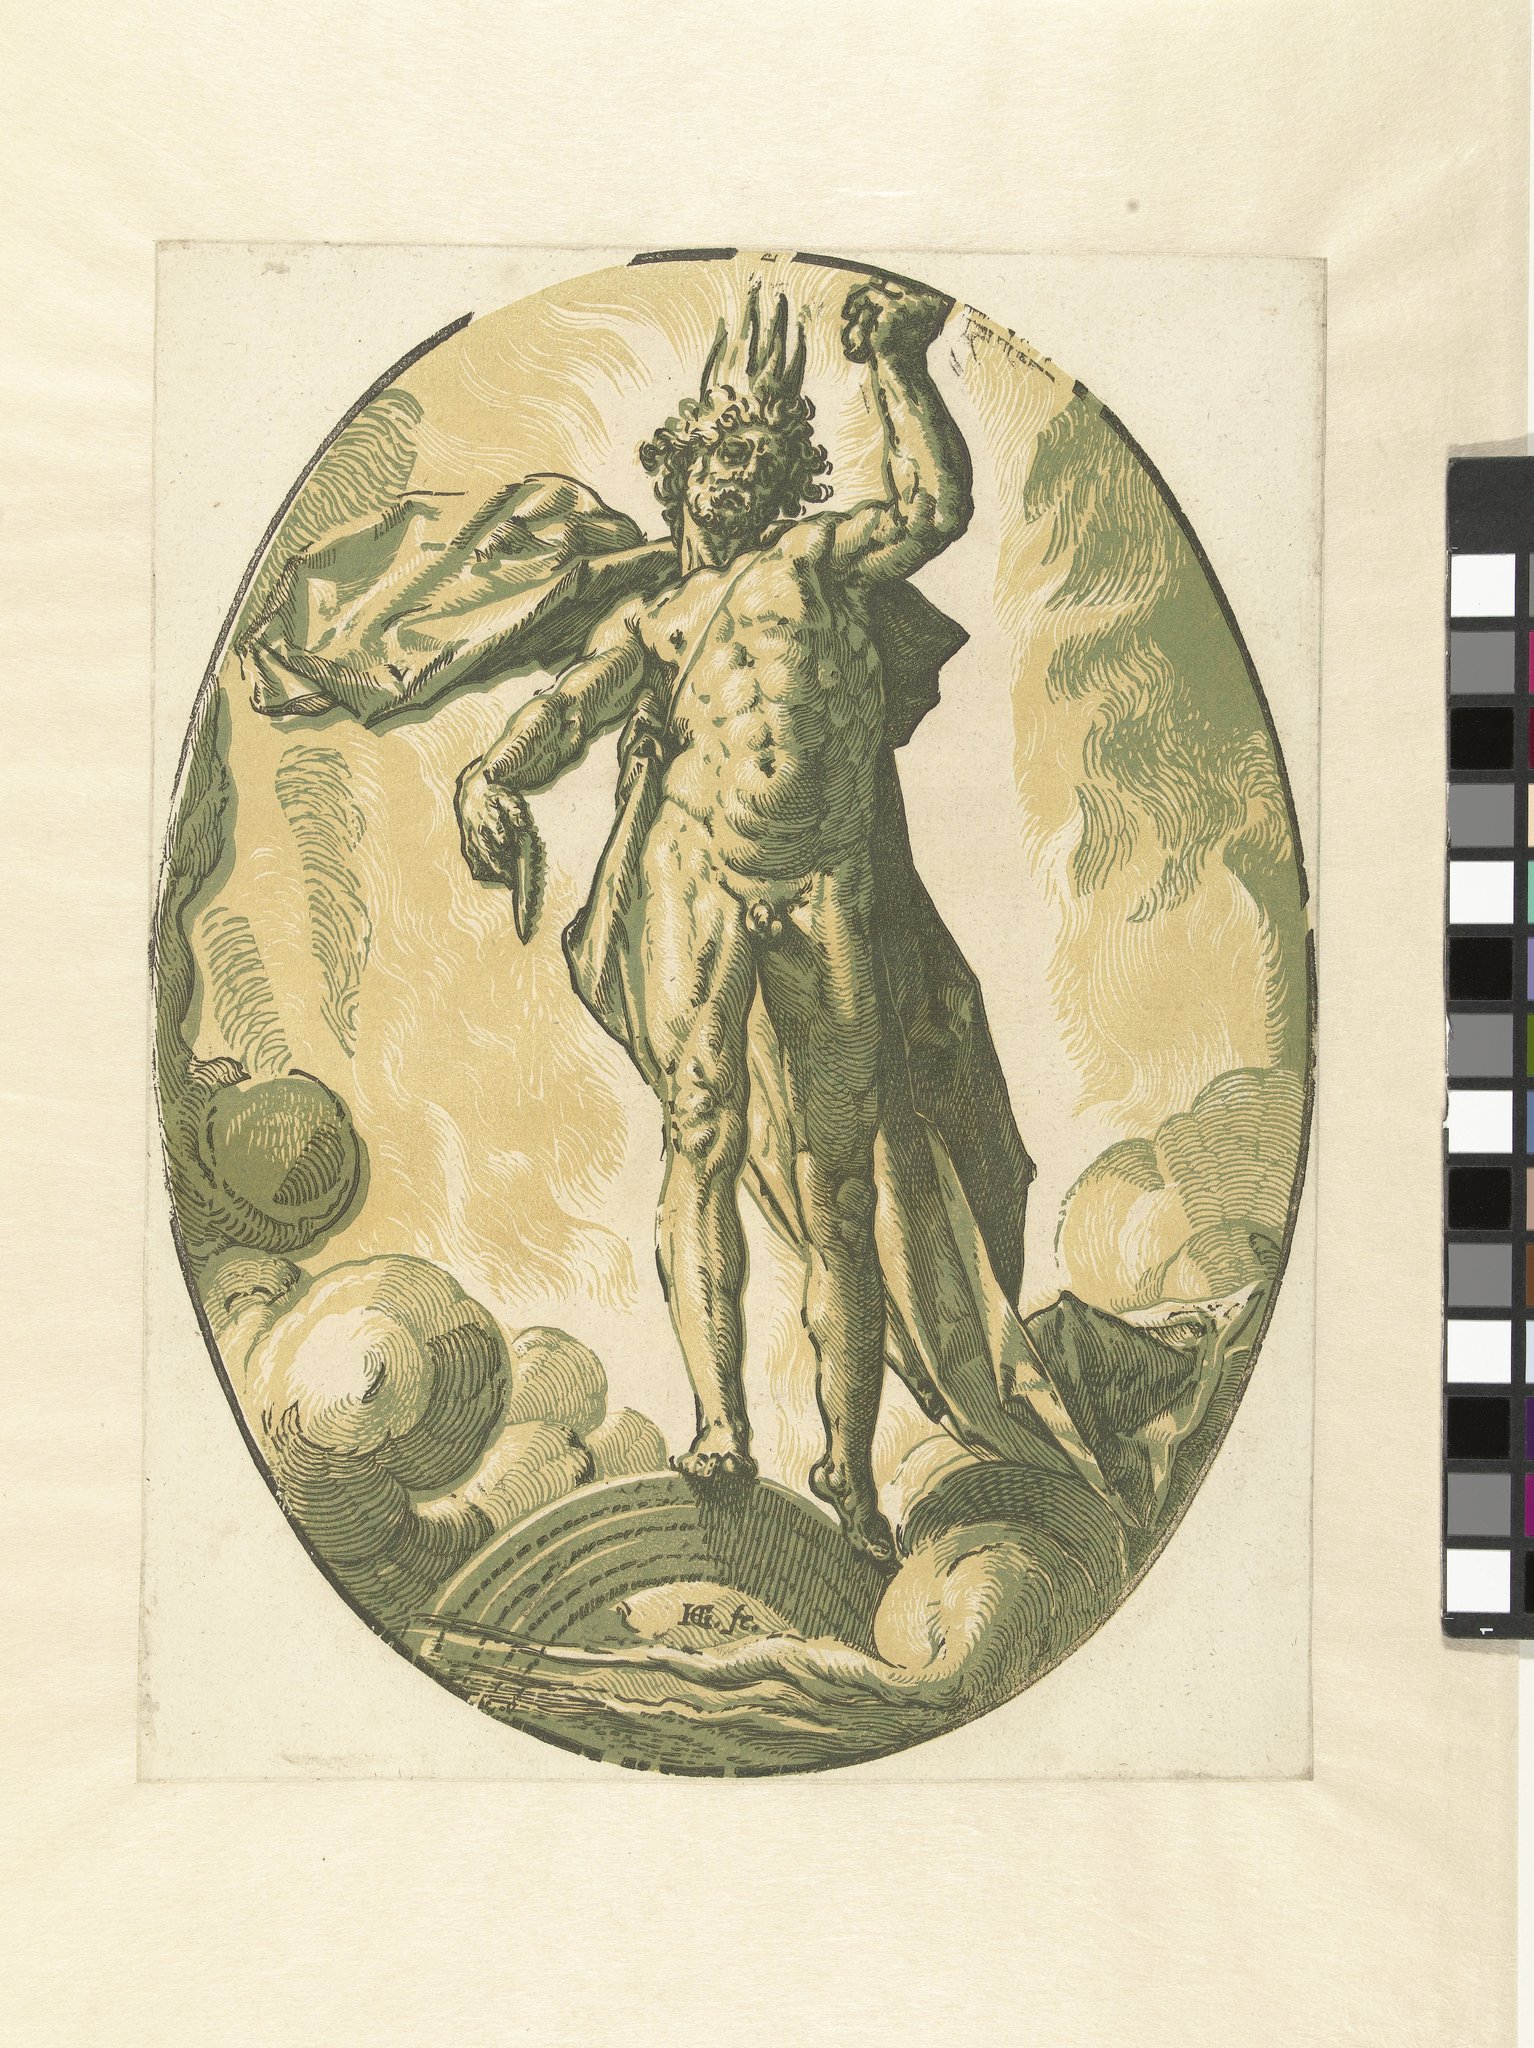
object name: print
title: Goden en godinnen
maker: hendrick goltzius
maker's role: draughtsman, painter, print maker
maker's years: 1558-1617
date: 1588-1590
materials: paper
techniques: woodcut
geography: haarlem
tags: other primeval deities (with name), apollo as sun-god, i.e. sol (helius), titan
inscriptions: collector's mark: Lugt 240, collector's mark: Lugt 2228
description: De god Helios of Dies (Dag), staand tussen wolken op een regenboog, omgeven door vlammen. Deze prent is onderdeel van een serie van zeven ovale prenten van klassieke goden en godinnen.